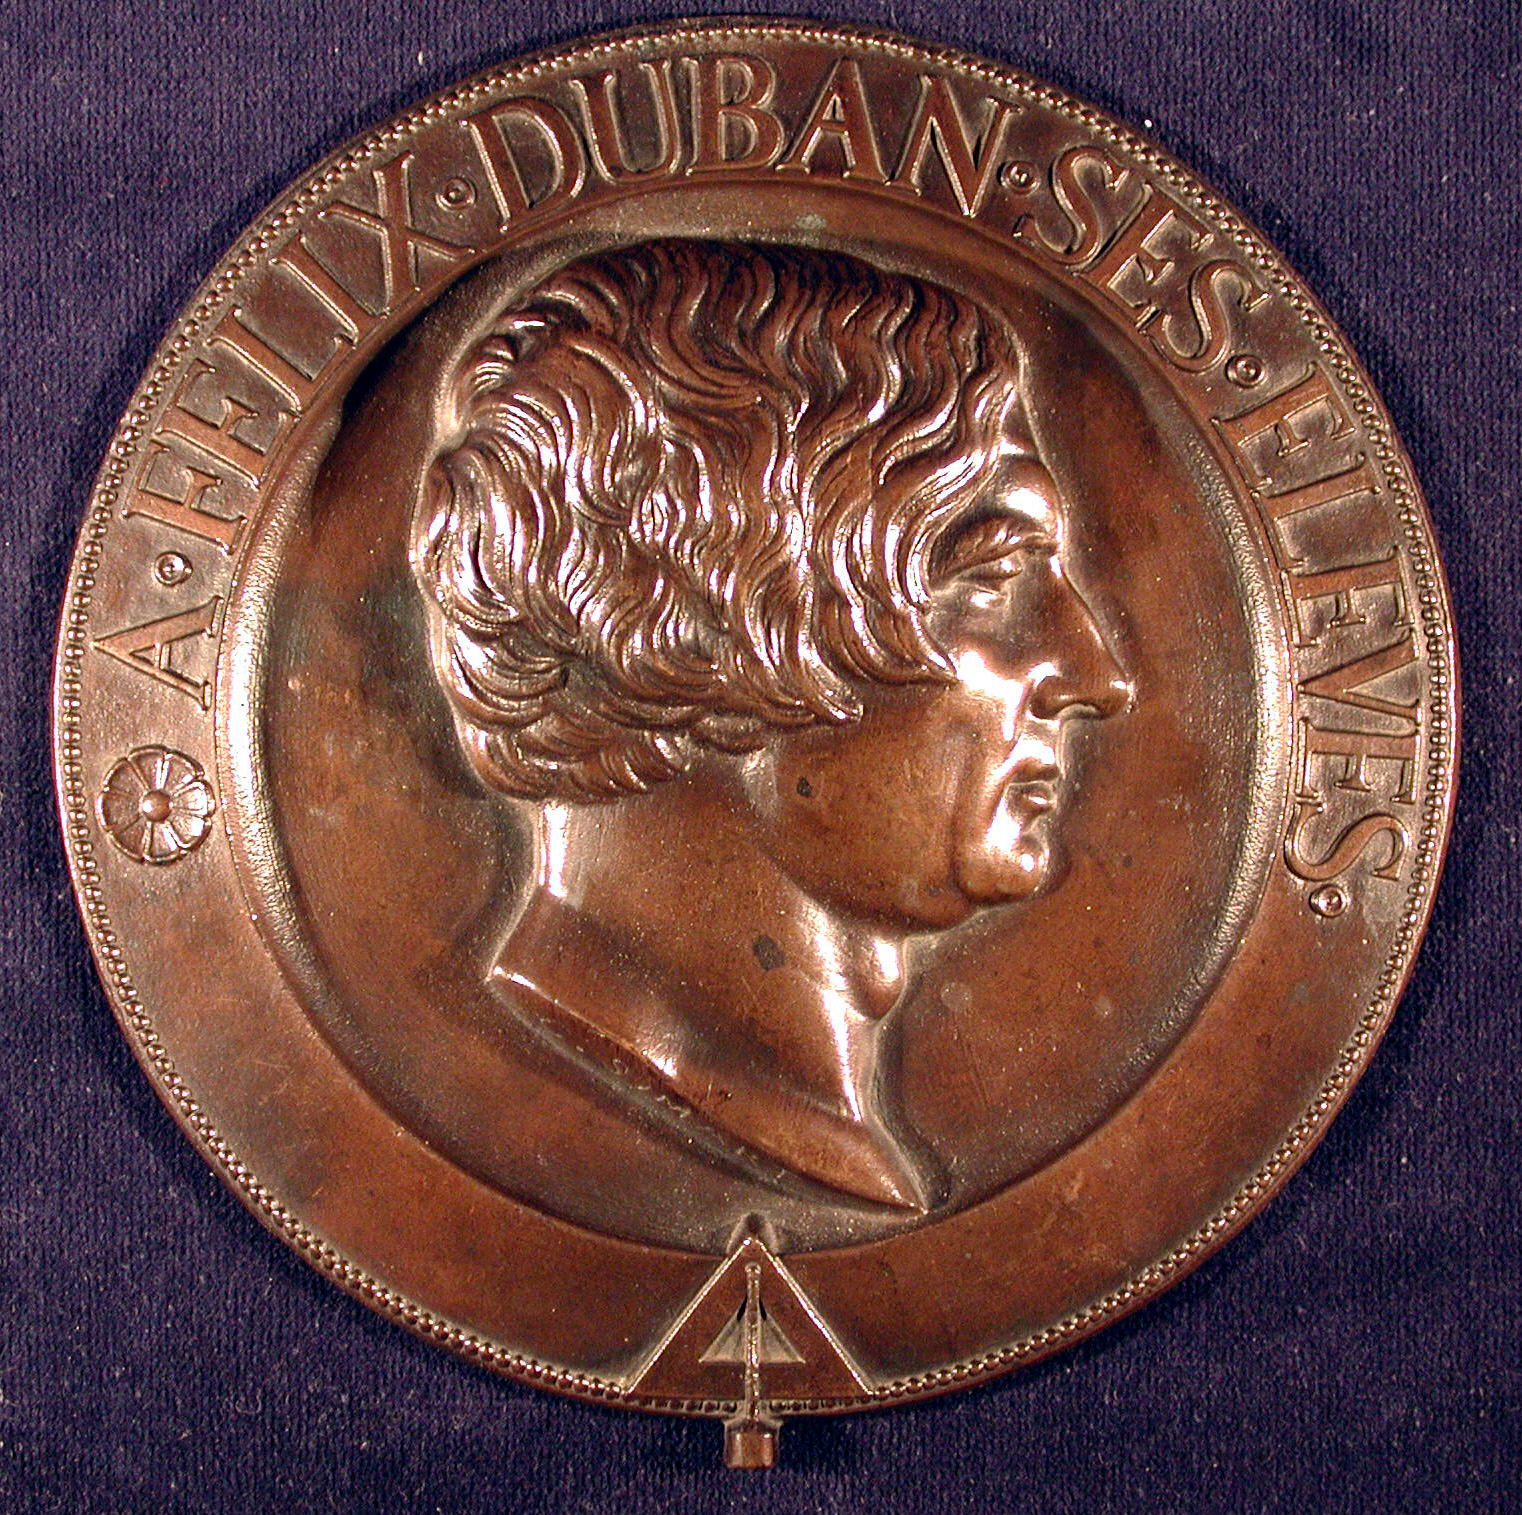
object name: portrait medallion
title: The Architect Félix Duban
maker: pierre-charles simart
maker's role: maker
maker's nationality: french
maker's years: 1806-1857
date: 1840-1850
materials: bronze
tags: men,profiles